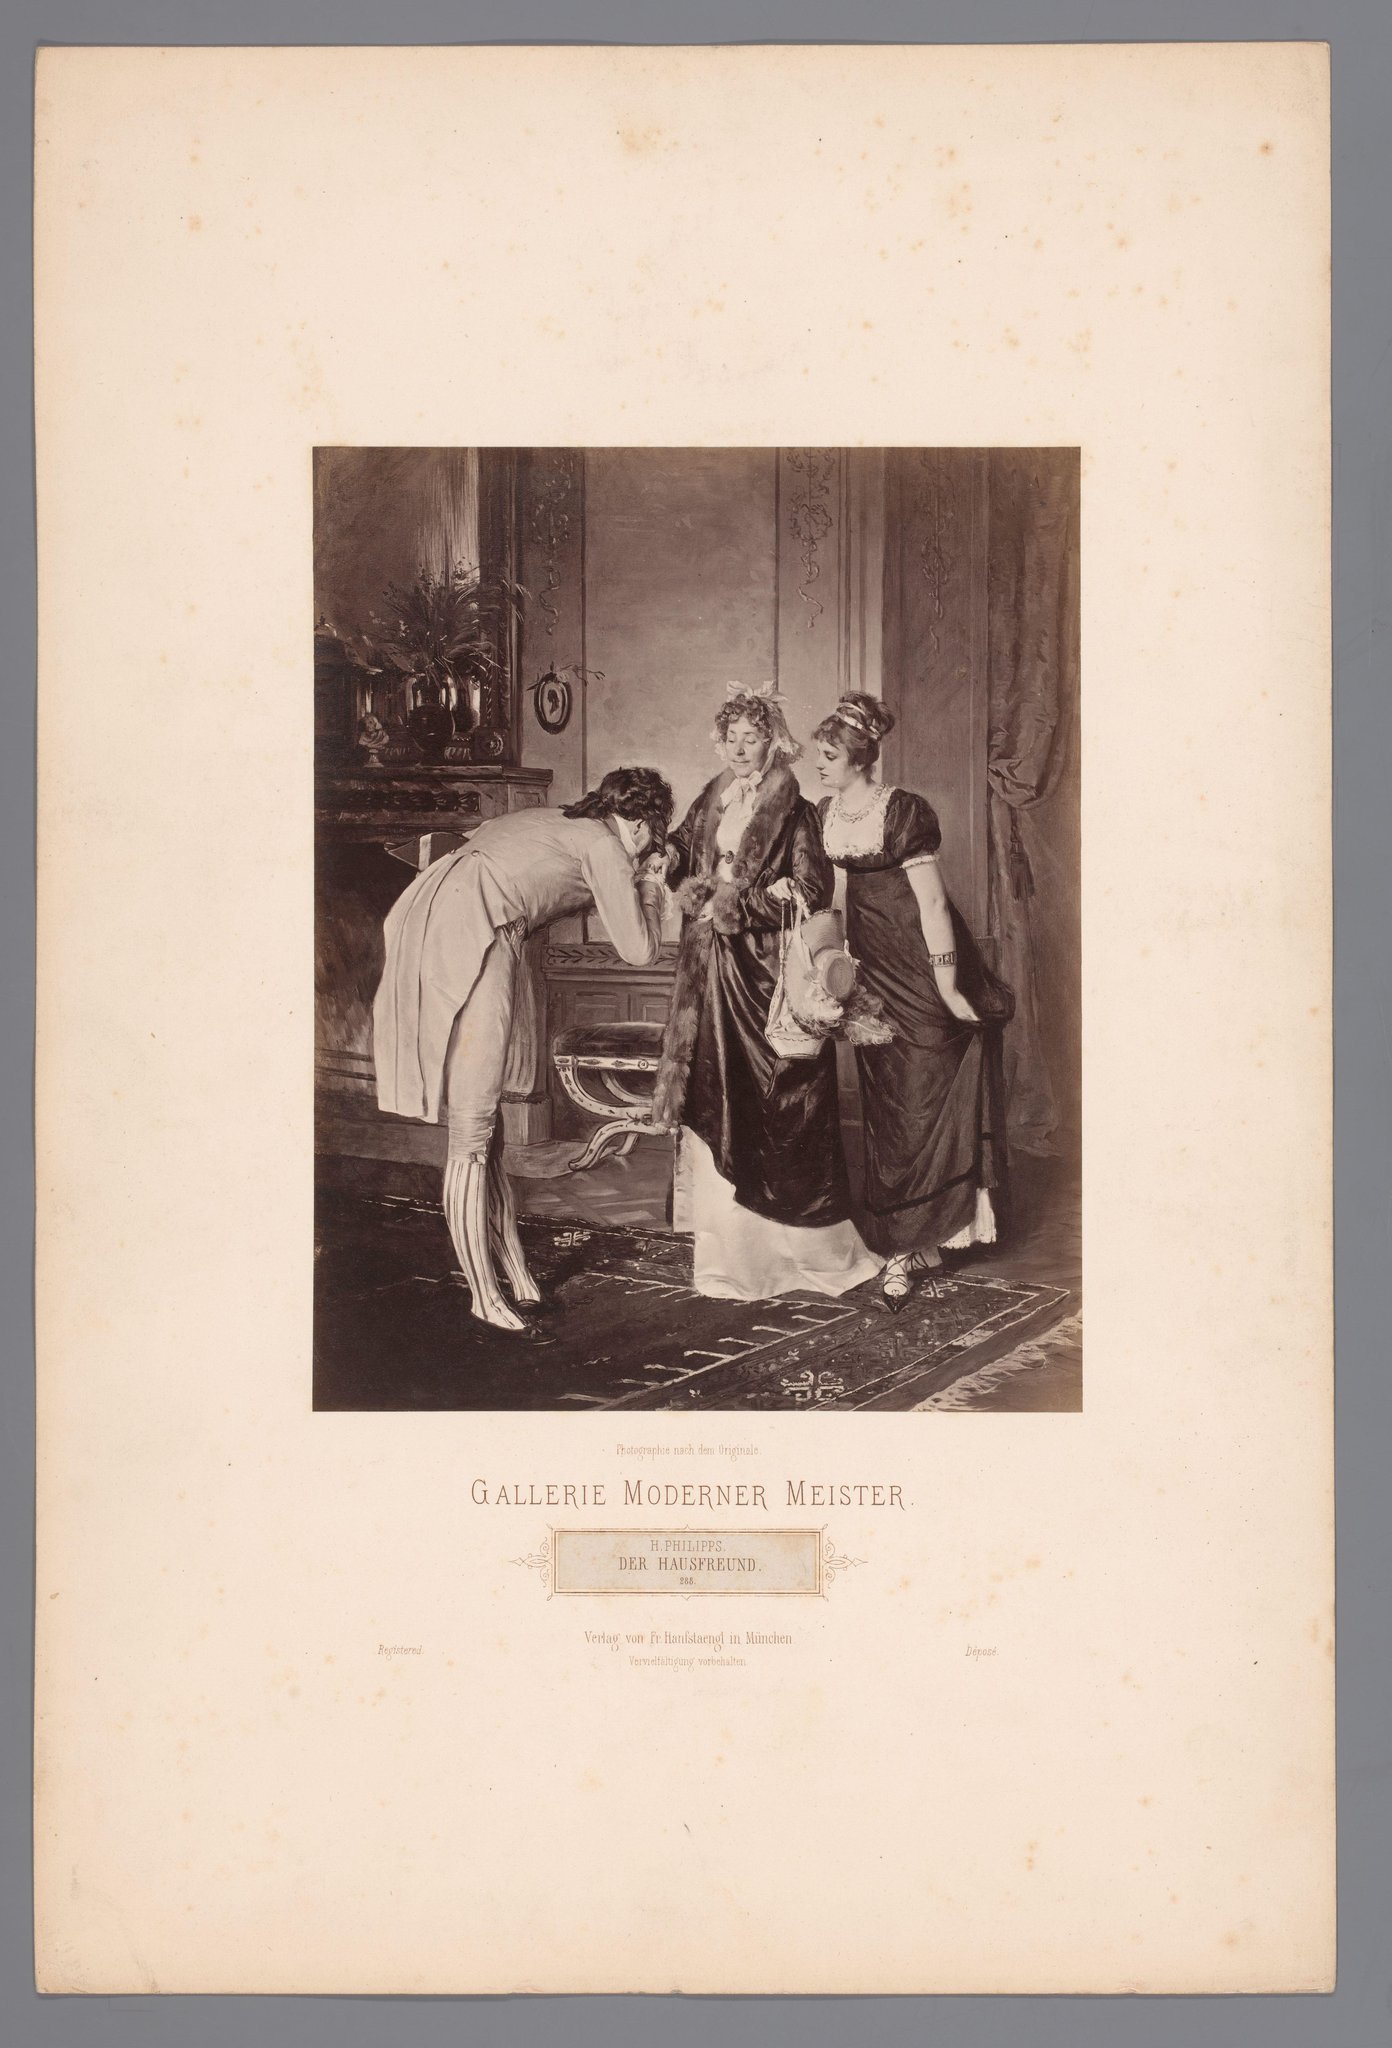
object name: photograph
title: Gallerie Moderner Meister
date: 1880-1900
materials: cardboard, paper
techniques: albumen print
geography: munich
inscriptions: caption: ‘Photographie nach dem Originale.//GALLERIE MODERNER MEISTER//H.Phillipps.//DER HAUSFREUND.//registered Verlag von Fr. Hanfstaengl in München//Vervielfältigung vorbehalten//Déposé’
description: Genretafereel met twee dames en een man.